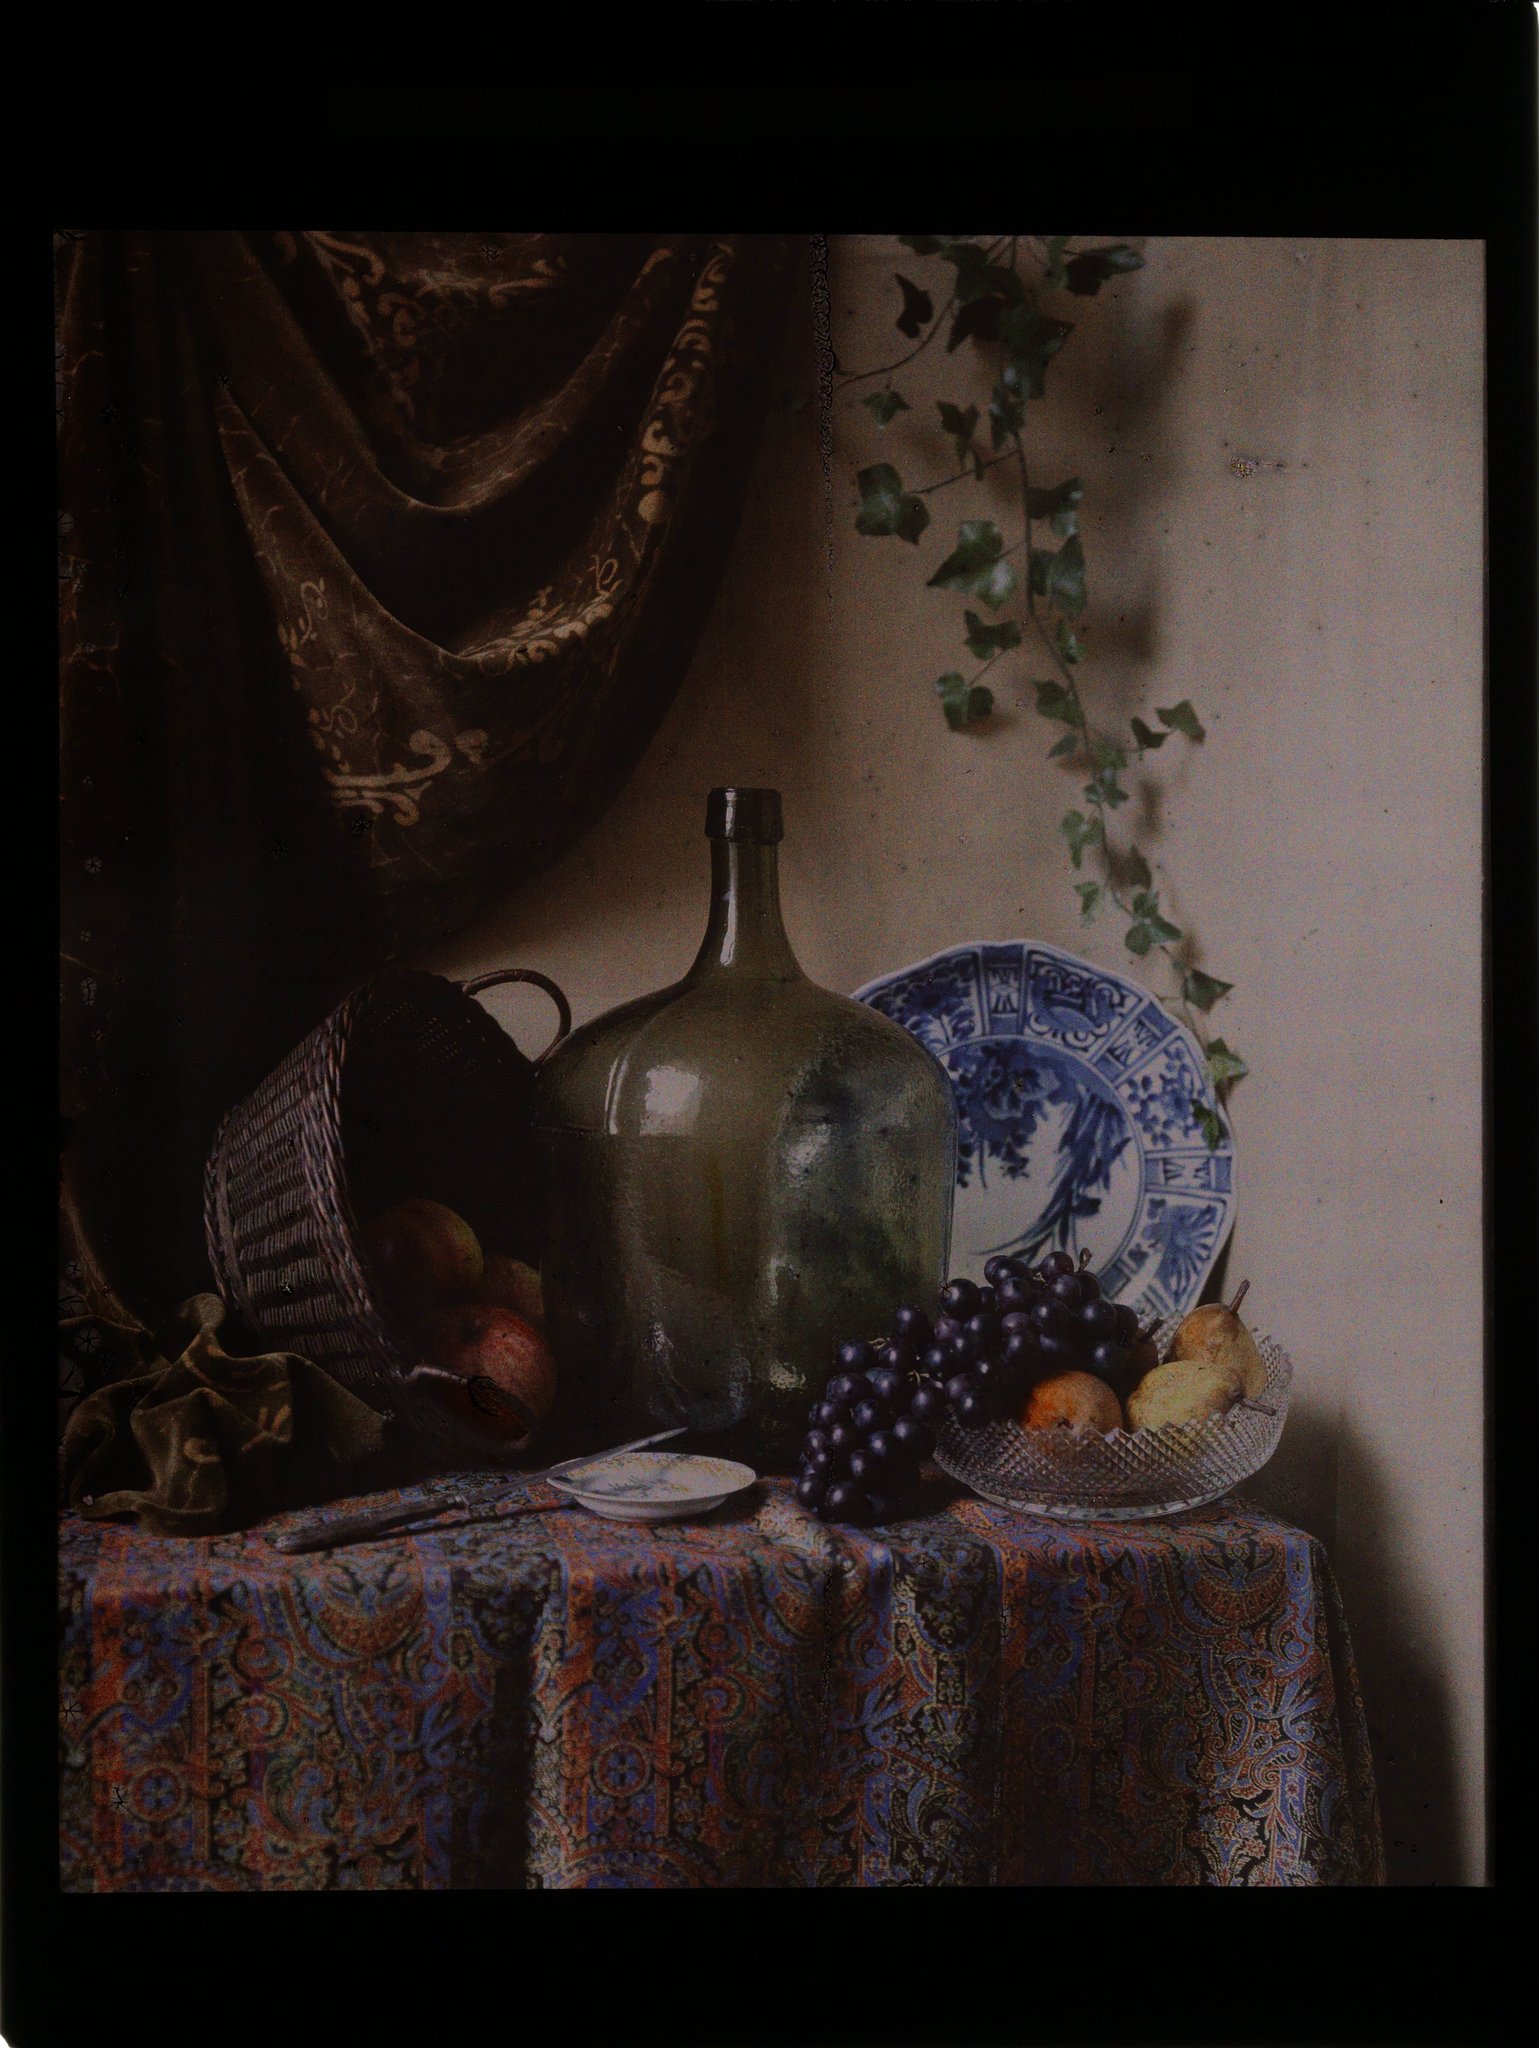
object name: photograph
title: Stilleven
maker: Anonymous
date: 1907-1935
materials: glass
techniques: autochrome process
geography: netherlands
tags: fruit, still life of related objects, netherlands